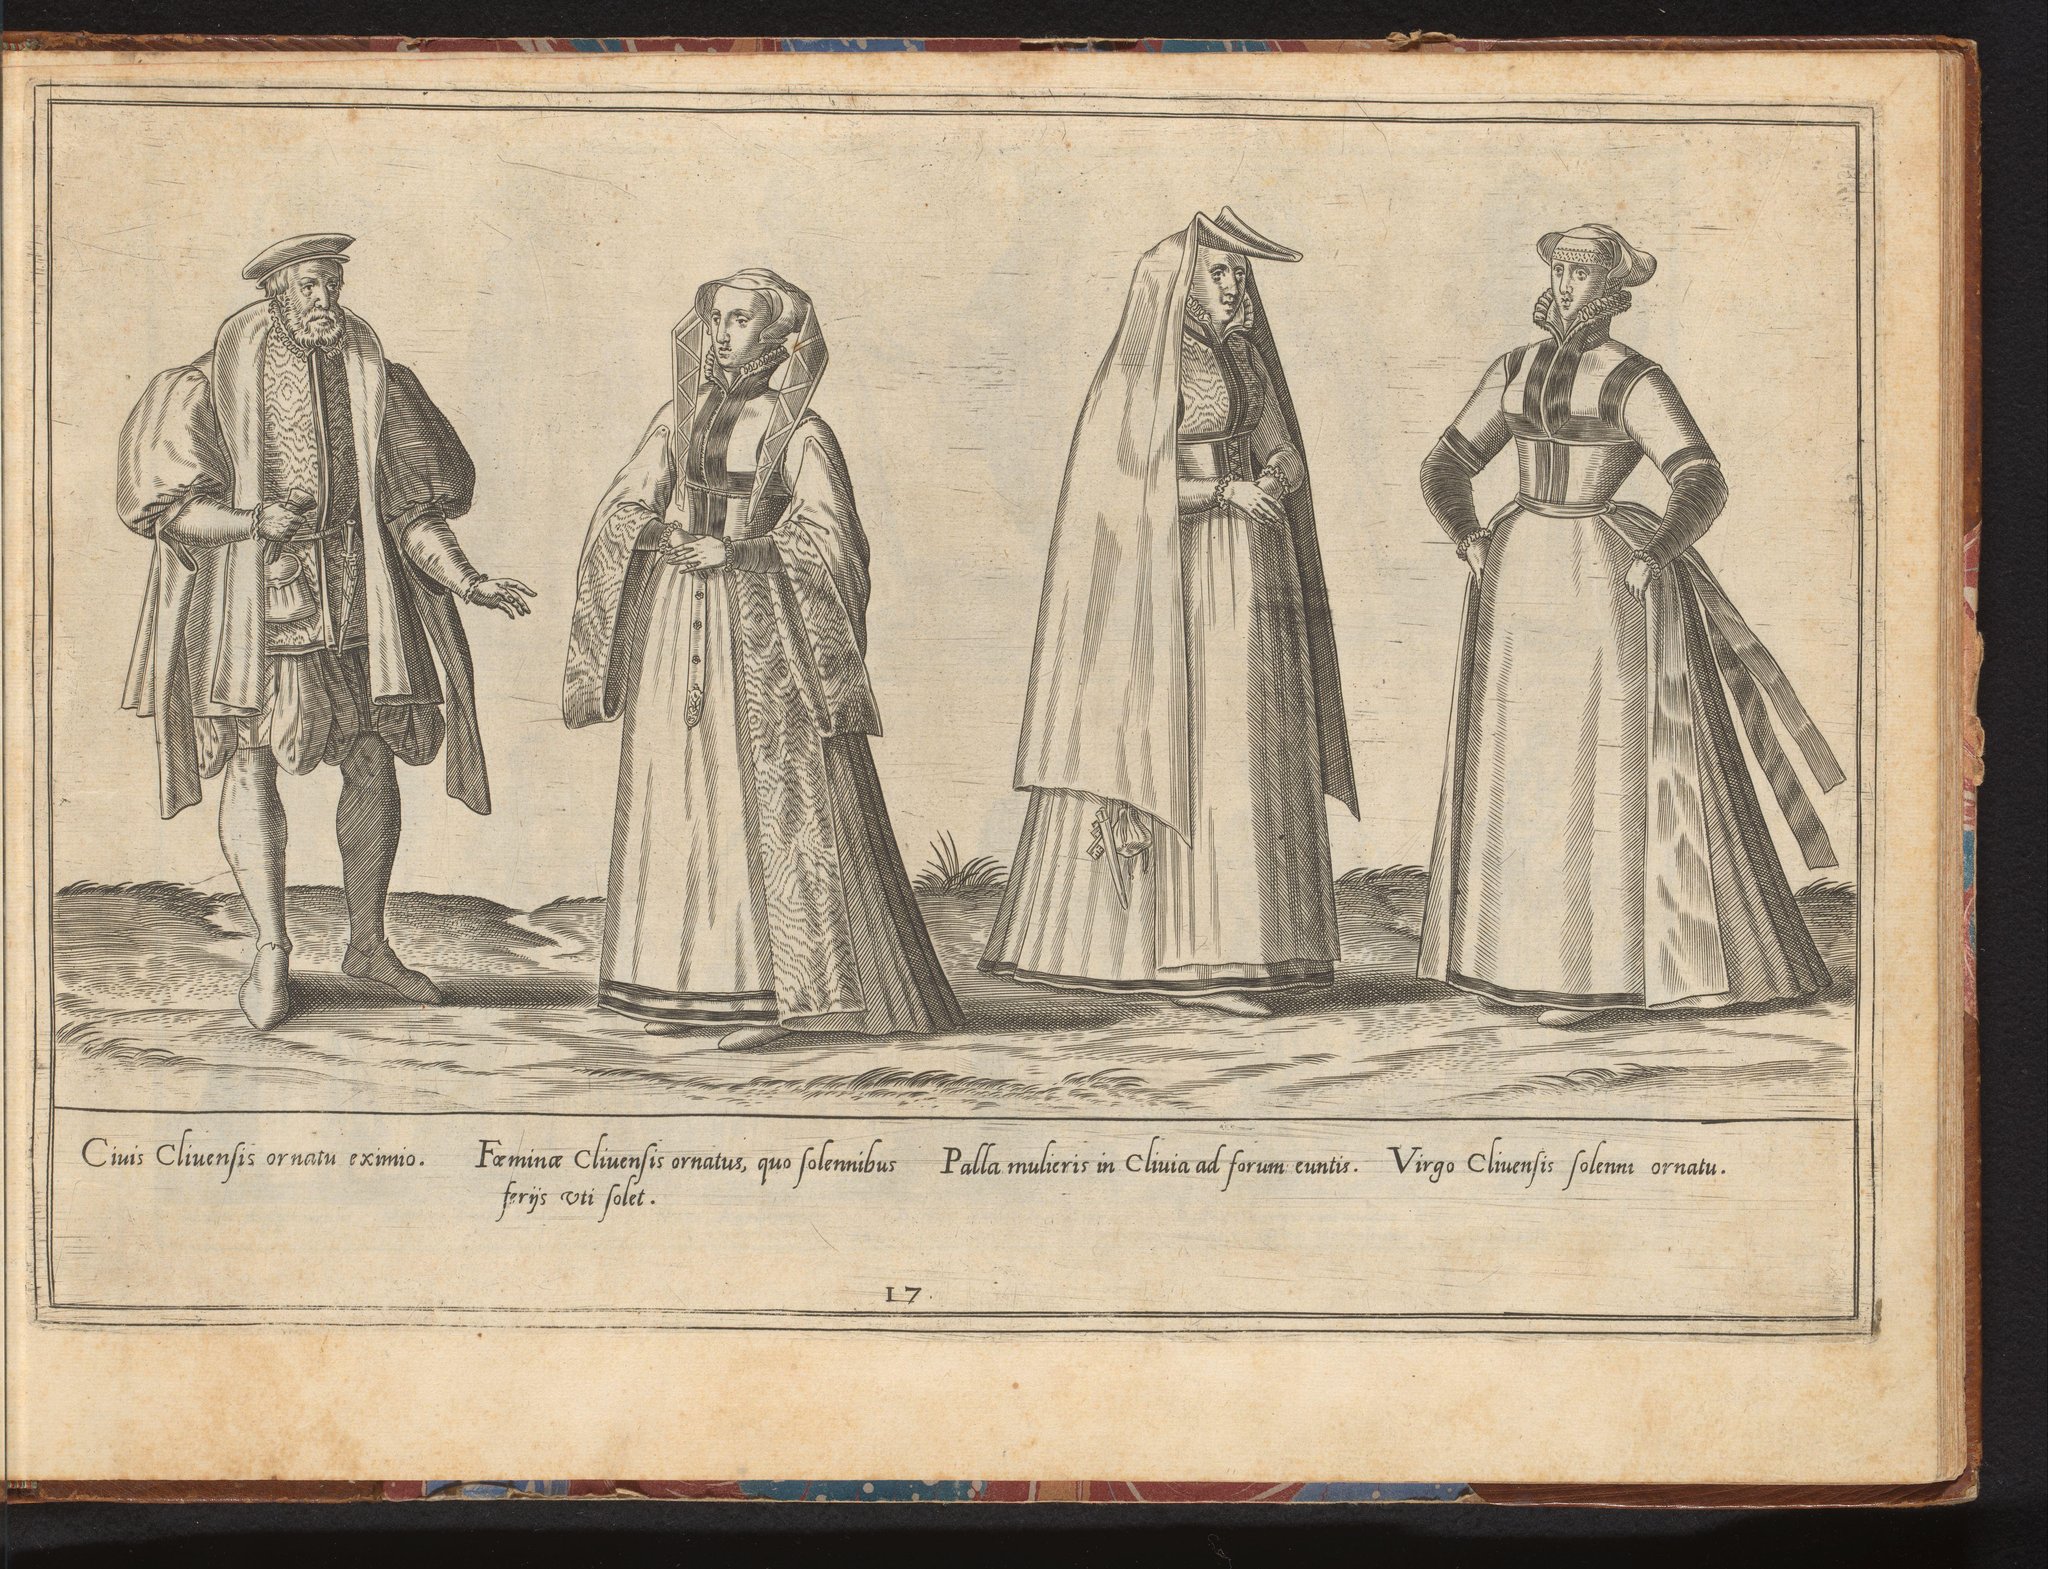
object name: album leaf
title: Drie vrouwen en een man, gekleed volgens de mode van ca. 1580 in Kleef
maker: abraham de bruyn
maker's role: print maker, publisher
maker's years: 1540-1587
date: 1581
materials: paper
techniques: engraving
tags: europeans: germans (+ women), europeans: germans (+ men), europeans: germans (+ costume), clothes, costume (+ men's clothes)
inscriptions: number: ‘17’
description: Prent uit het boek 'Omnium pene Europae, Asiae, Aphricae atque Americae gentium habitus...', 1581. De prent maakt deel uit van een album.